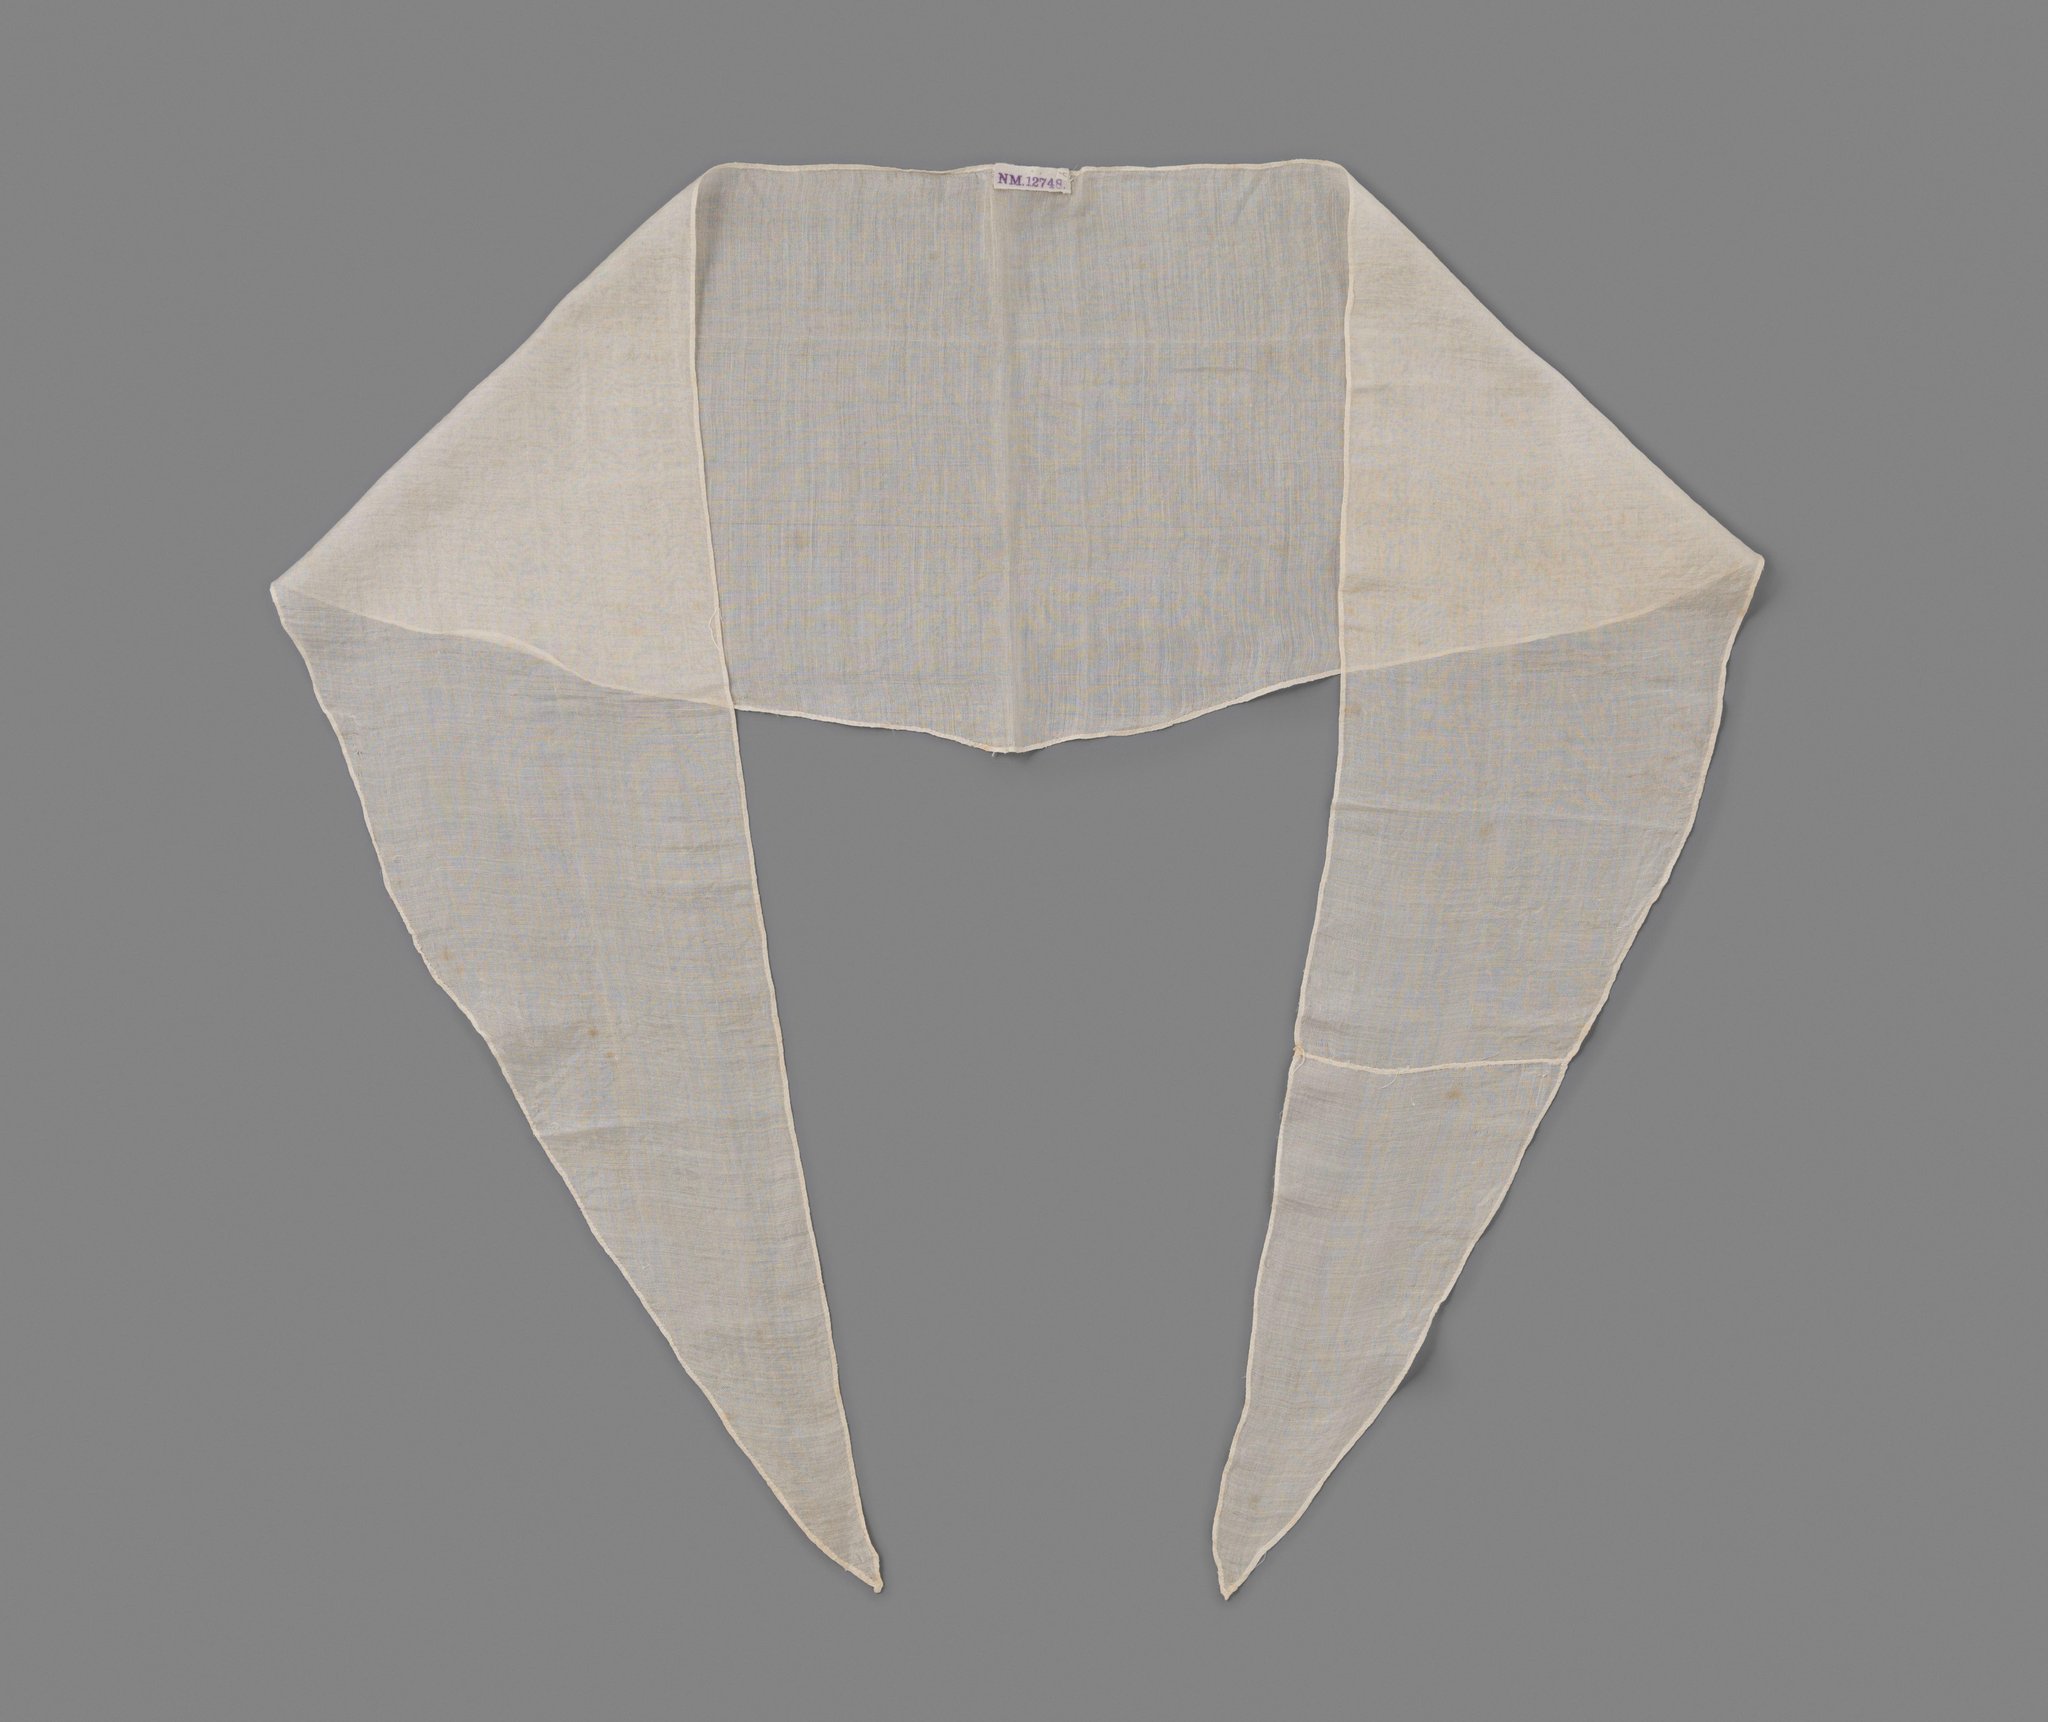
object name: fichu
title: Fichu van zijde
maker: Anonymous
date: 1790-1810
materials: silk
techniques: weave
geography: netherlands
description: Fichu van zijde, voorzien van smal rolzoompje.